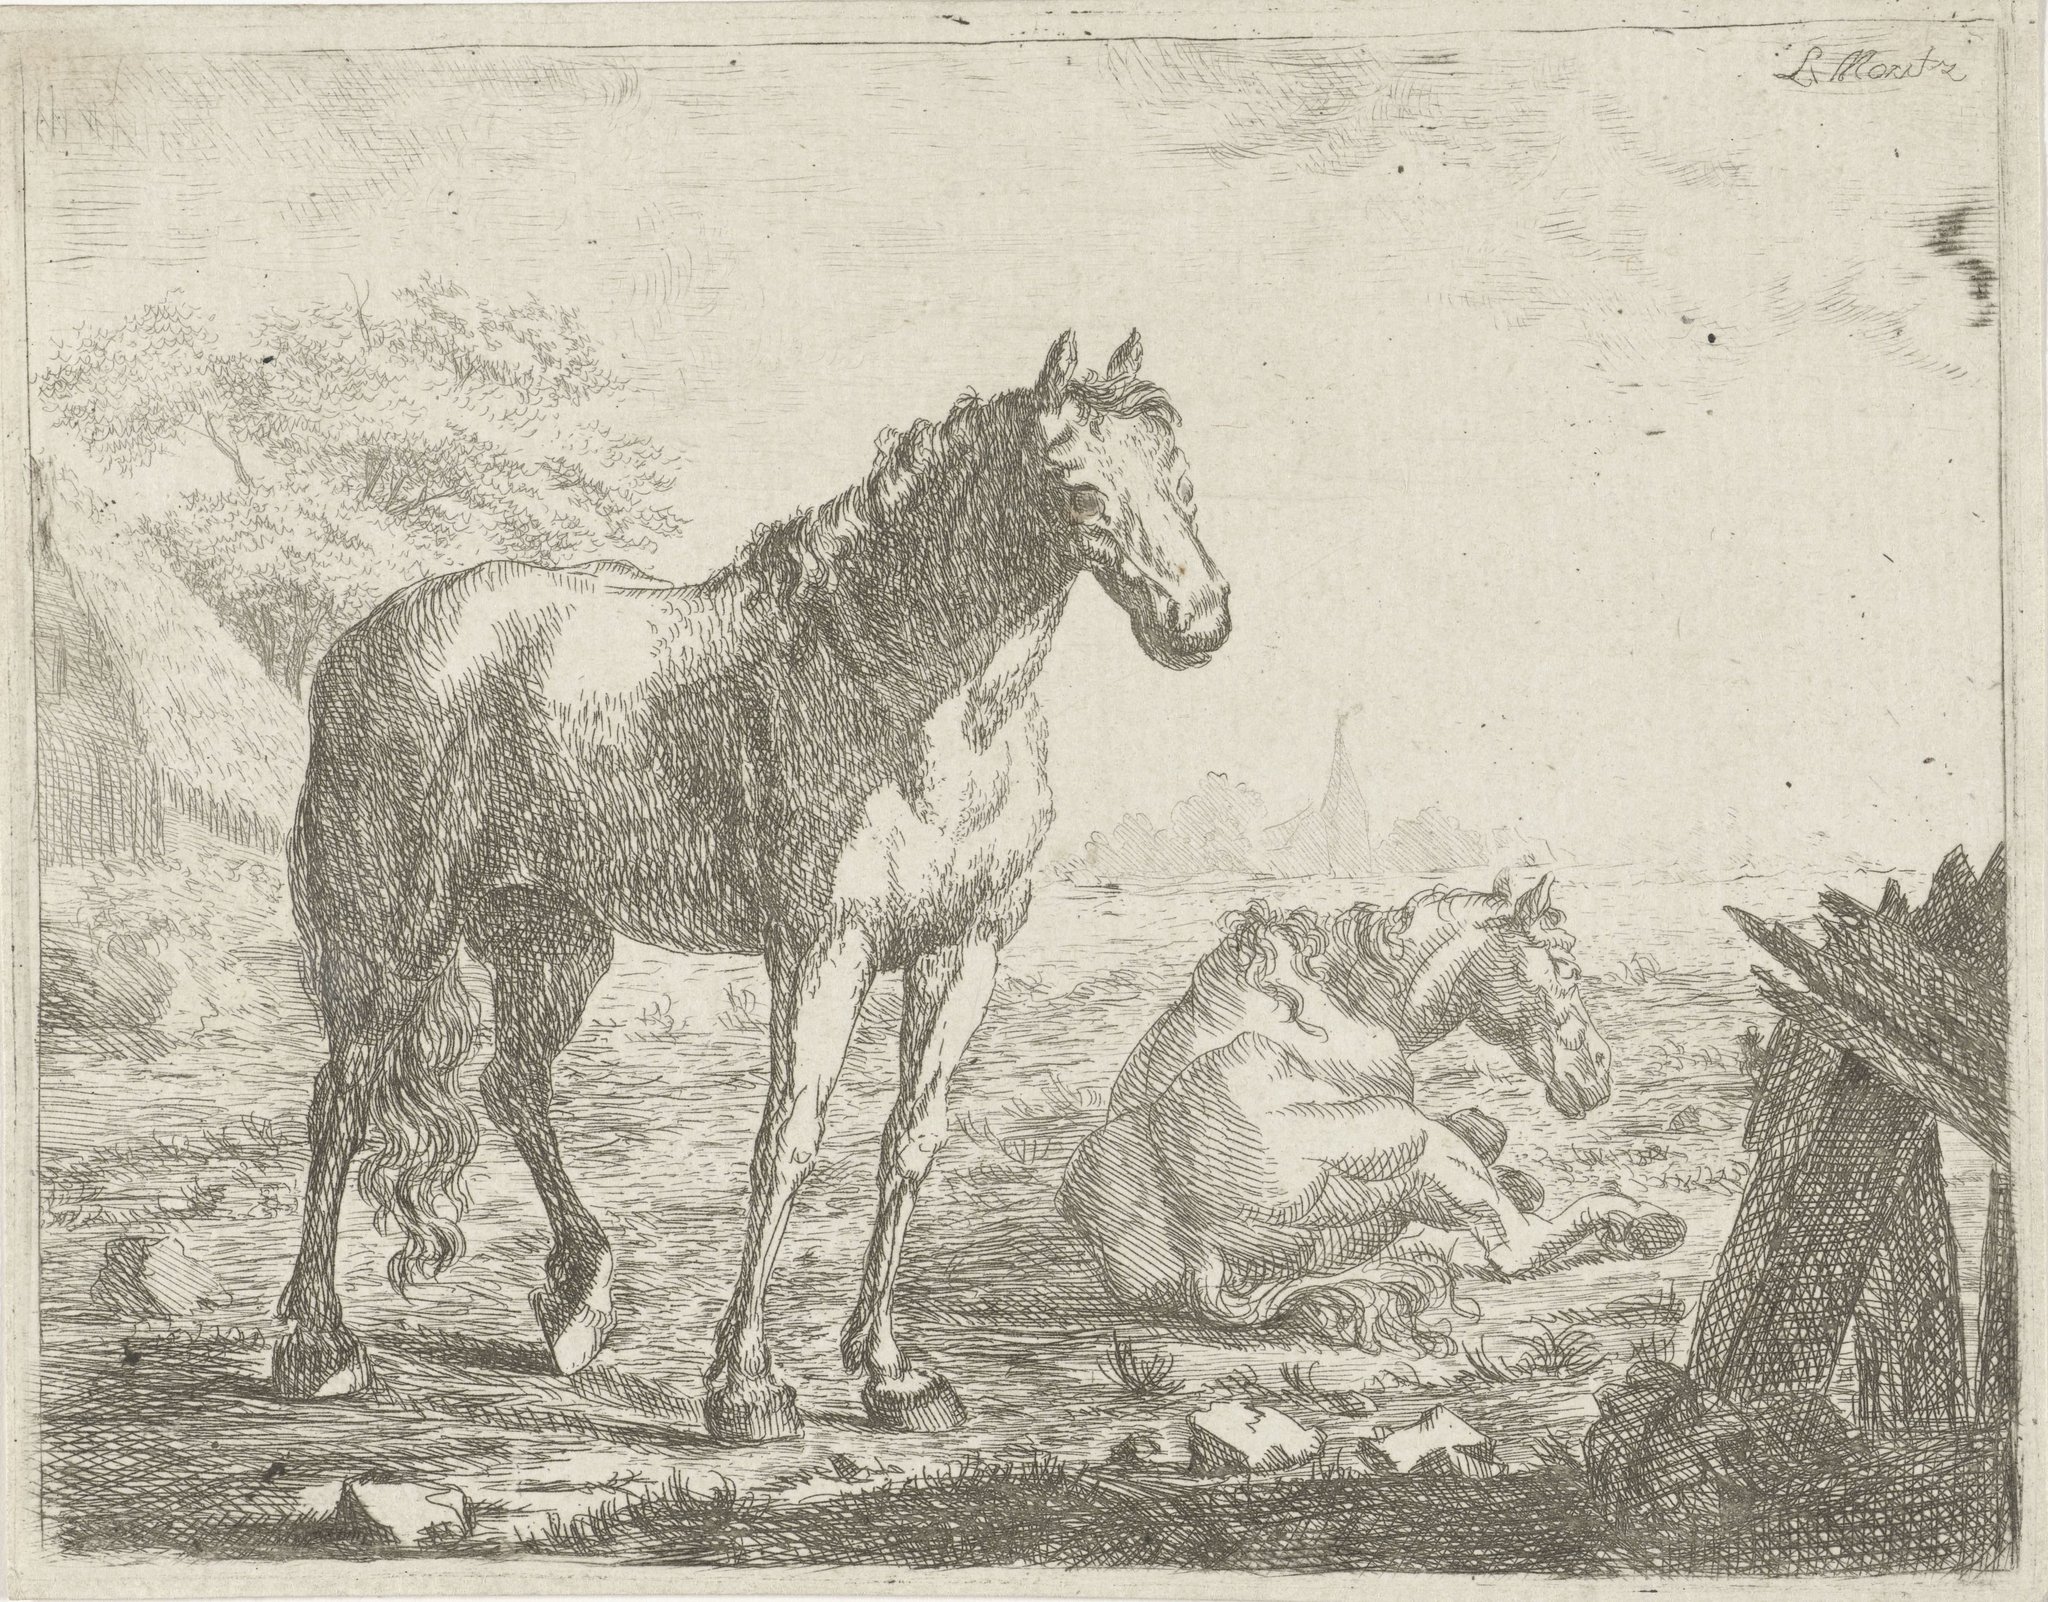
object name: print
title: Twee paarden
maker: louis moritz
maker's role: draughtsman, painter, print maker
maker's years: 1773-1850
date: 1783-1850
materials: paper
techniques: etching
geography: netherlands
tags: meadow, pasture, horse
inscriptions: collector's mark: Lugt 2228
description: Een staand en een liggend paard in een weiland.